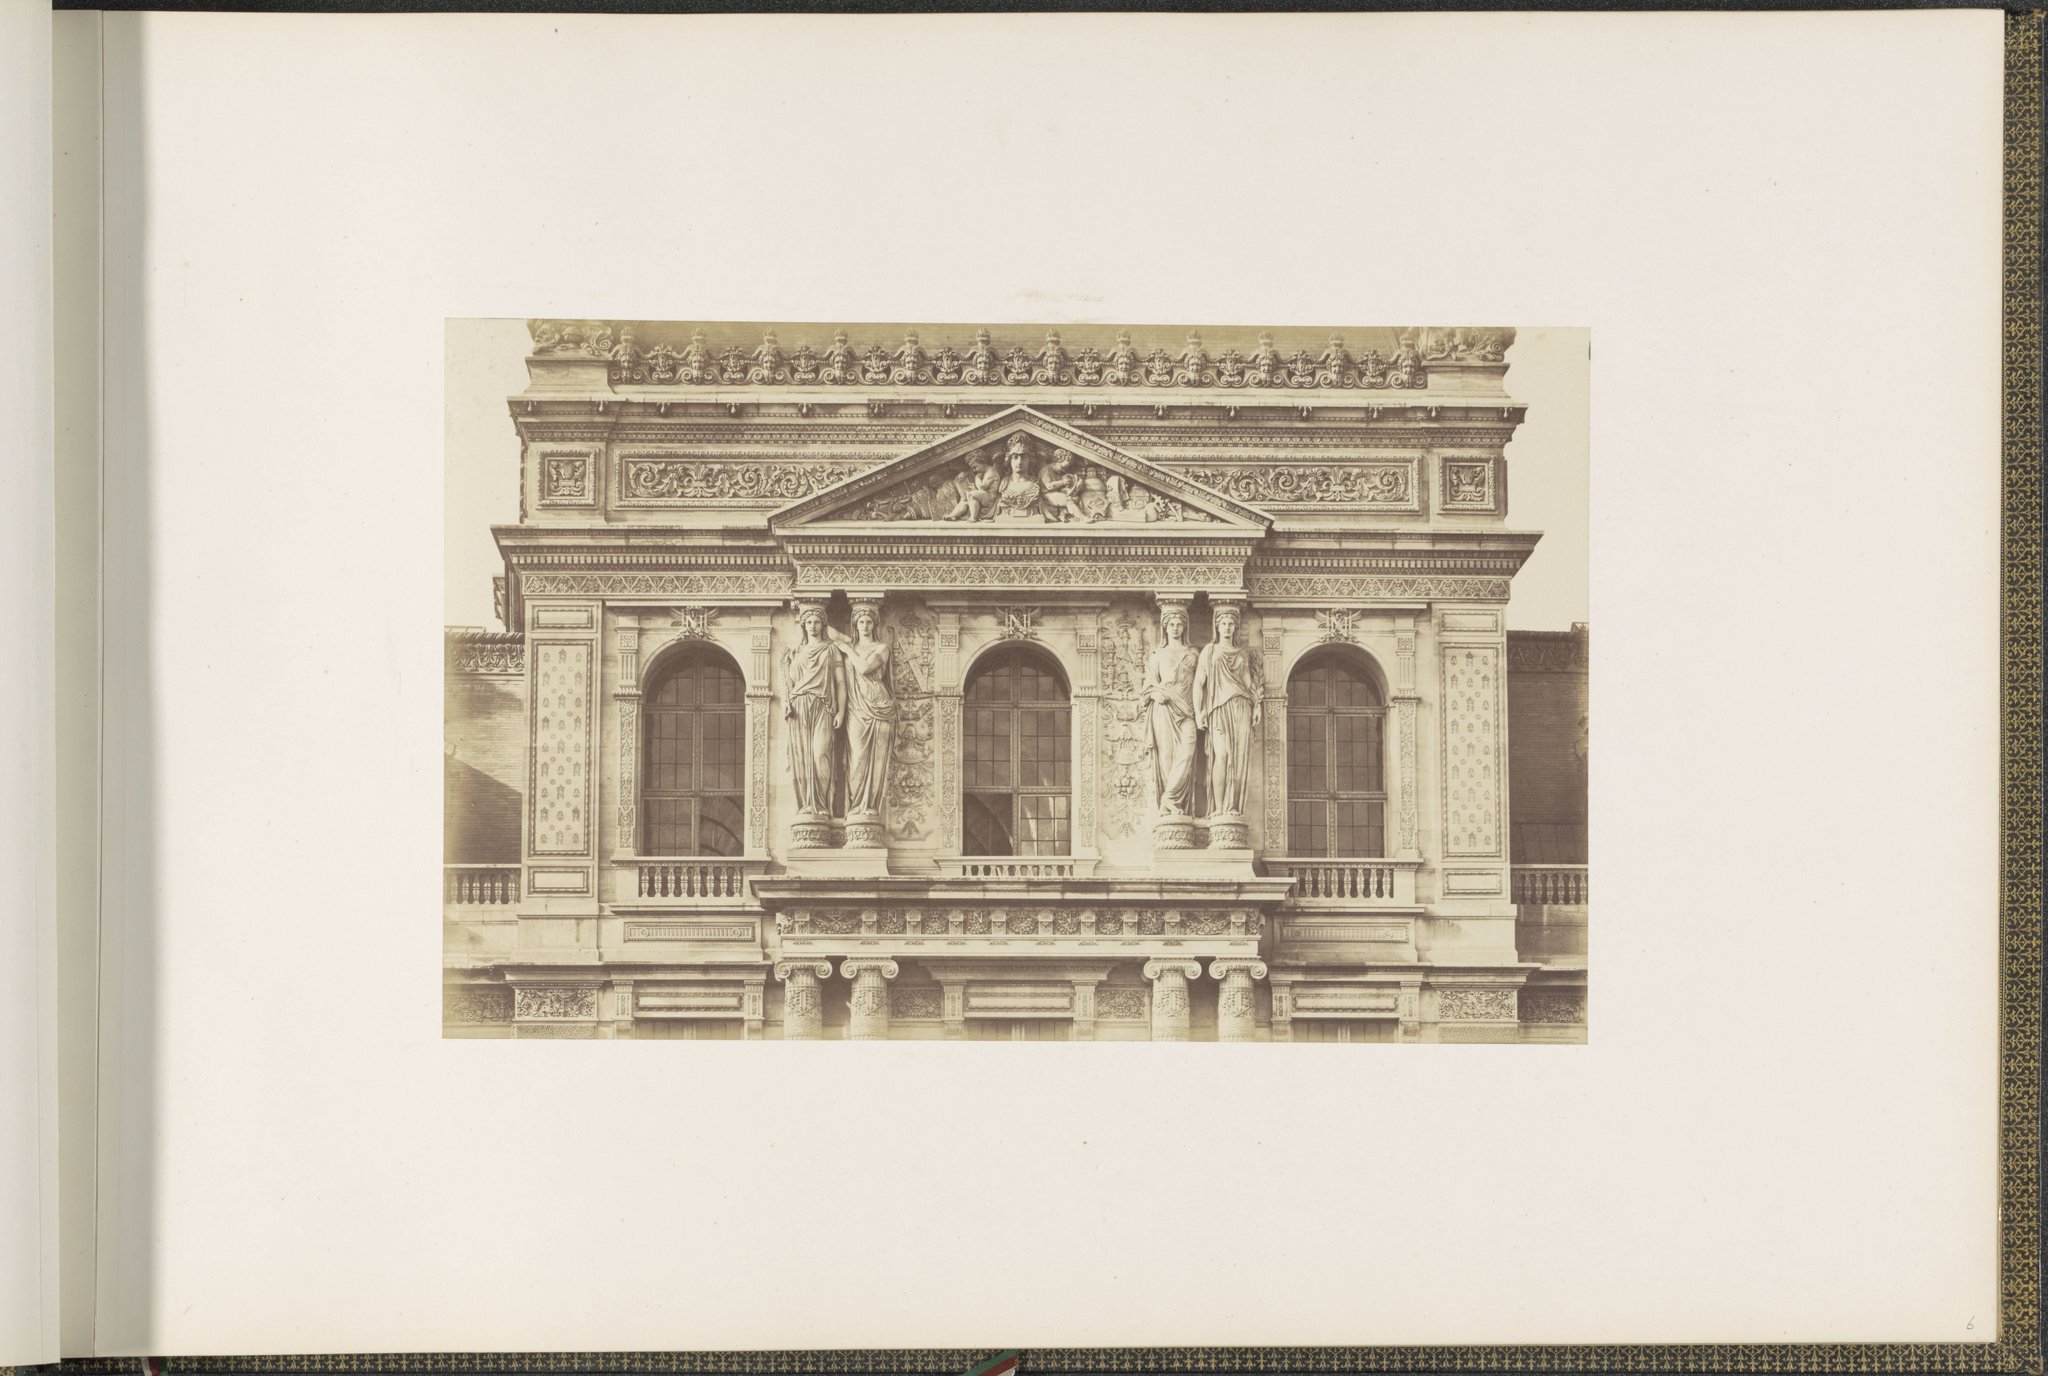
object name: photograph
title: Tweede verdieping van de Bibliothèque Impériale in het Palais du Louvre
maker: édouard denis baldus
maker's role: fotograaf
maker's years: 1813-1889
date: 1857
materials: paper, photographic support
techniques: salted paper print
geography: paris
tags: caryatids ~ architecture, other architectural details (with name), permanent exhibition, museum, façade (of house or building), paris, tuileries palace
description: Onderdeel van Réunion des Tuileries au Louvre 1852-1857, album 4.